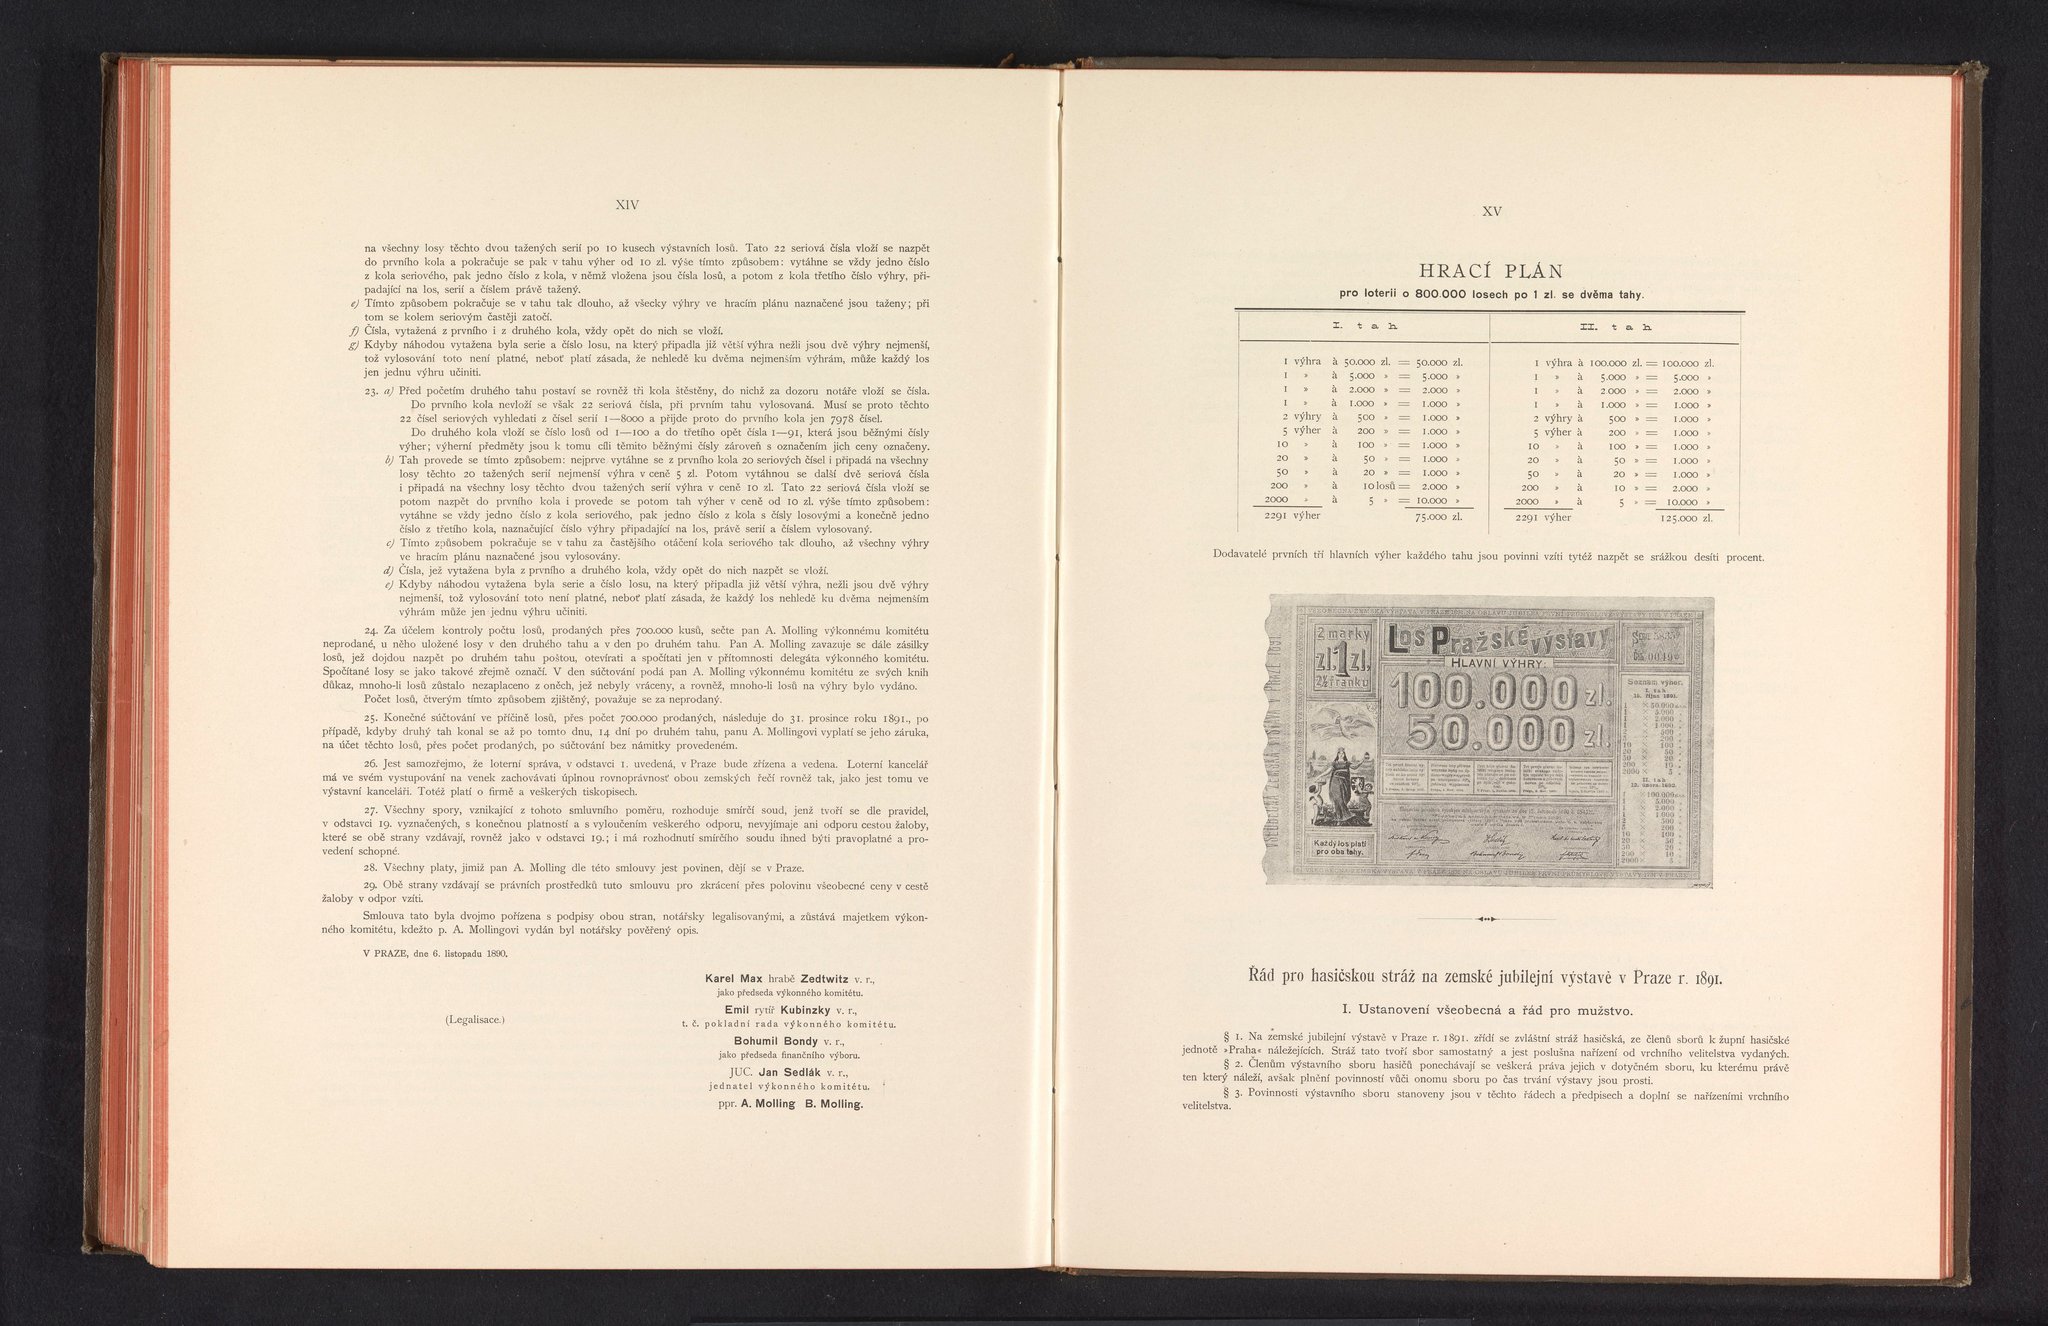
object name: page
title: Lot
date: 1891-1893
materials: paper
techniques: autotype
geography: prague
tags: raffle, lottery